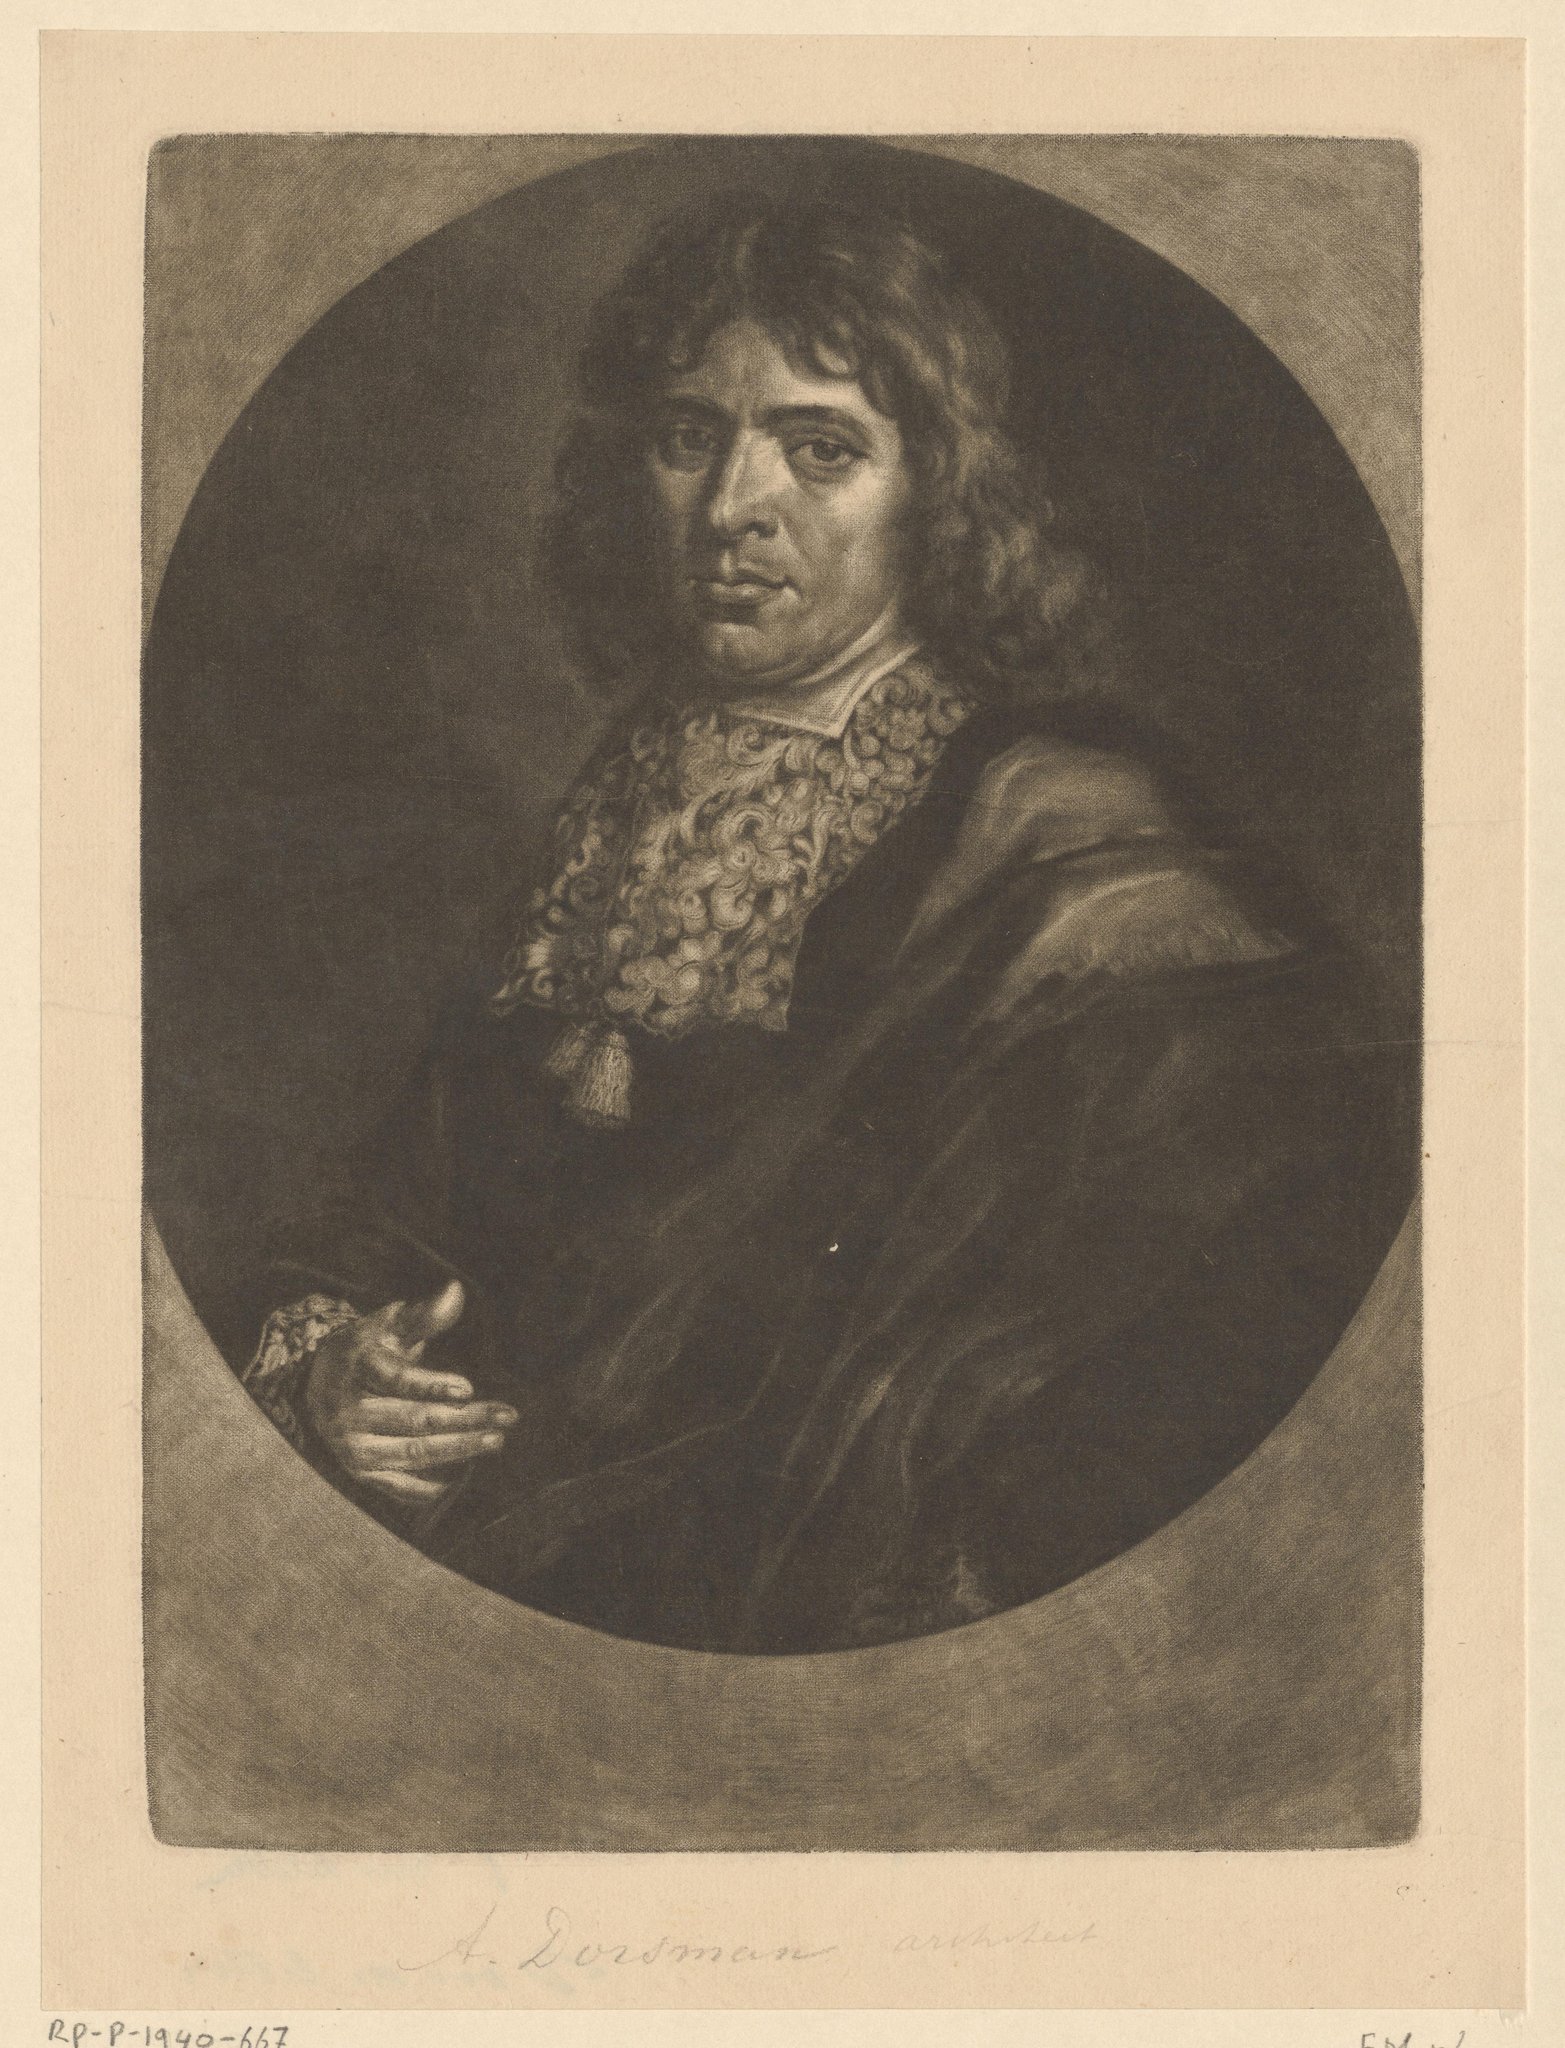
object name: print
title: Portret van Adriaan Dortsman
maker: pieter van der plas (ii)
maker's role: print maker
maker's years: 1647-1708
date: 1657-1708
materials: paper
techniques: mezzotint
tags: flushing, draughtsman, adriaan dortsman, portrait, self-portrait of architect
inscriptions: collector's mark: Lugt 2228, collector's mark: Lugt 2760